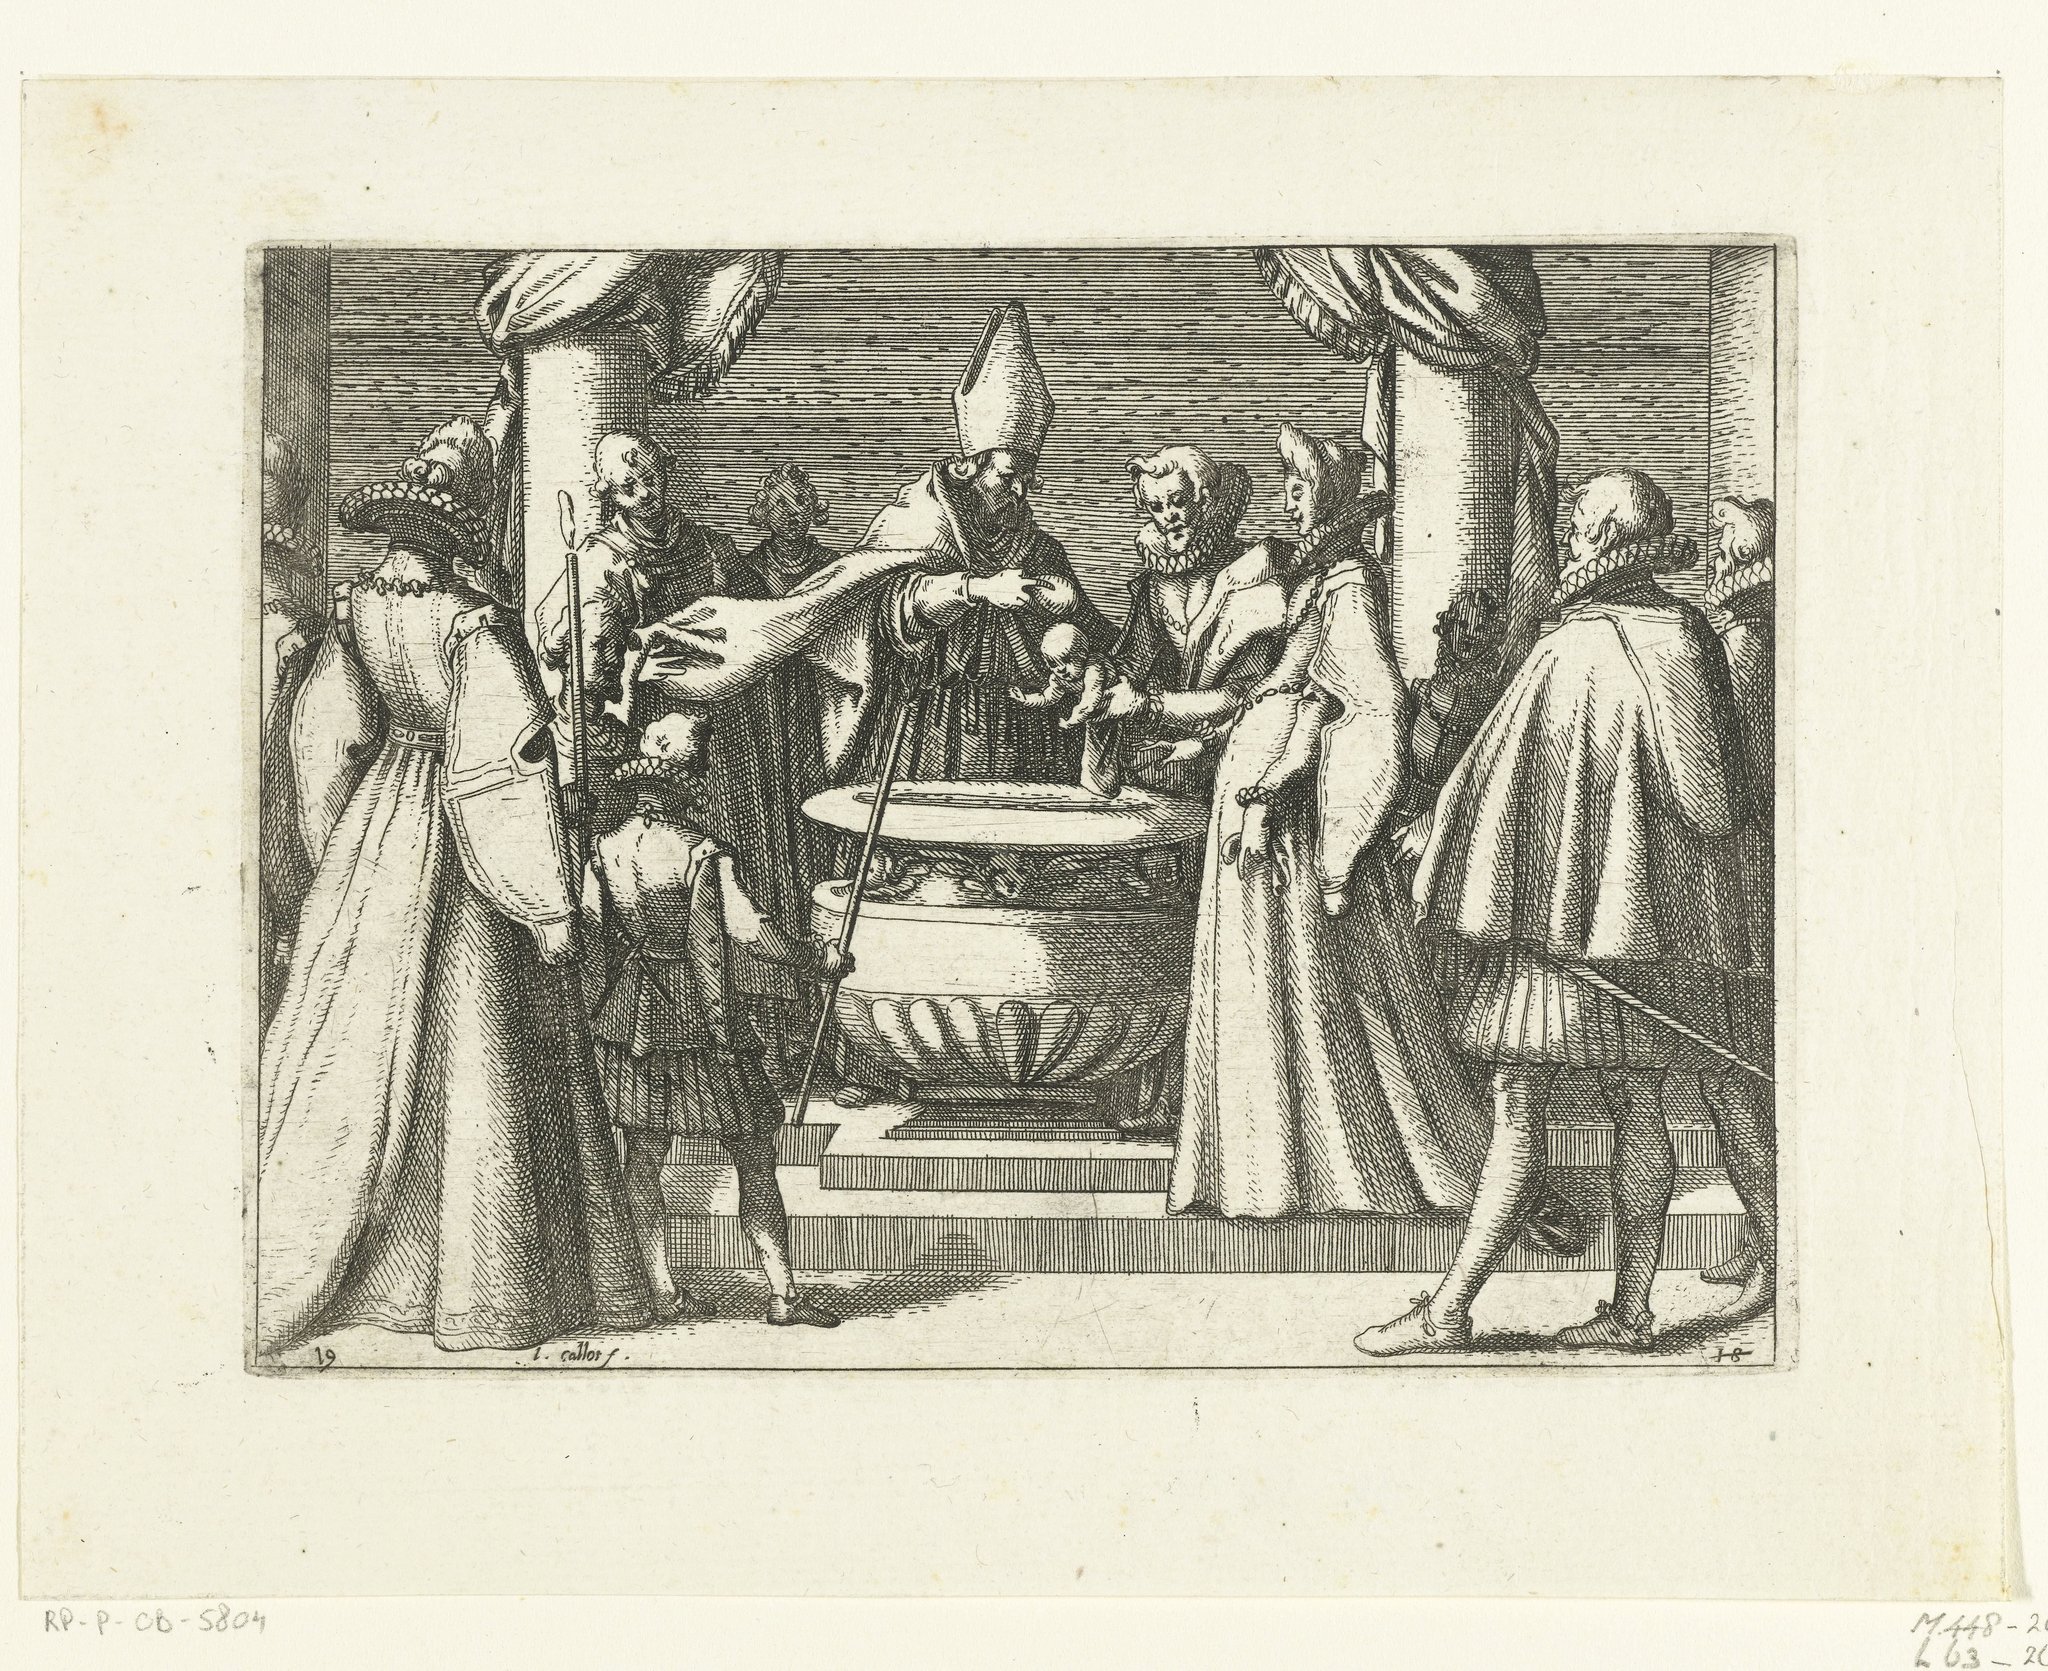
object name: print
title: Doop van de zoon van Margaretha van Oostenrijk en Filips III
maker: jacques callot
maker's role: draughtsman, print maker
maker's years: 1592-1635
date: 1612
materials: paper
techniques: etching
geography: florence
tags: filips iv (koning van spanje), margaretha van oostenrijk (koningin van spanje), filips iii (koning van spanje), baptism, christening ceremony ~ the first of the seven sacraments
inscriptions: collector's mark: Lugt 240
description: Als illustratie gebruikt in: Giovanni Altoviti, 'Essequie della sacra cattolica e real maesta di Margherita d'Austria' (Florence: Bartolomeo Sermatelli e fratelli, 1612). Klinkert, C.